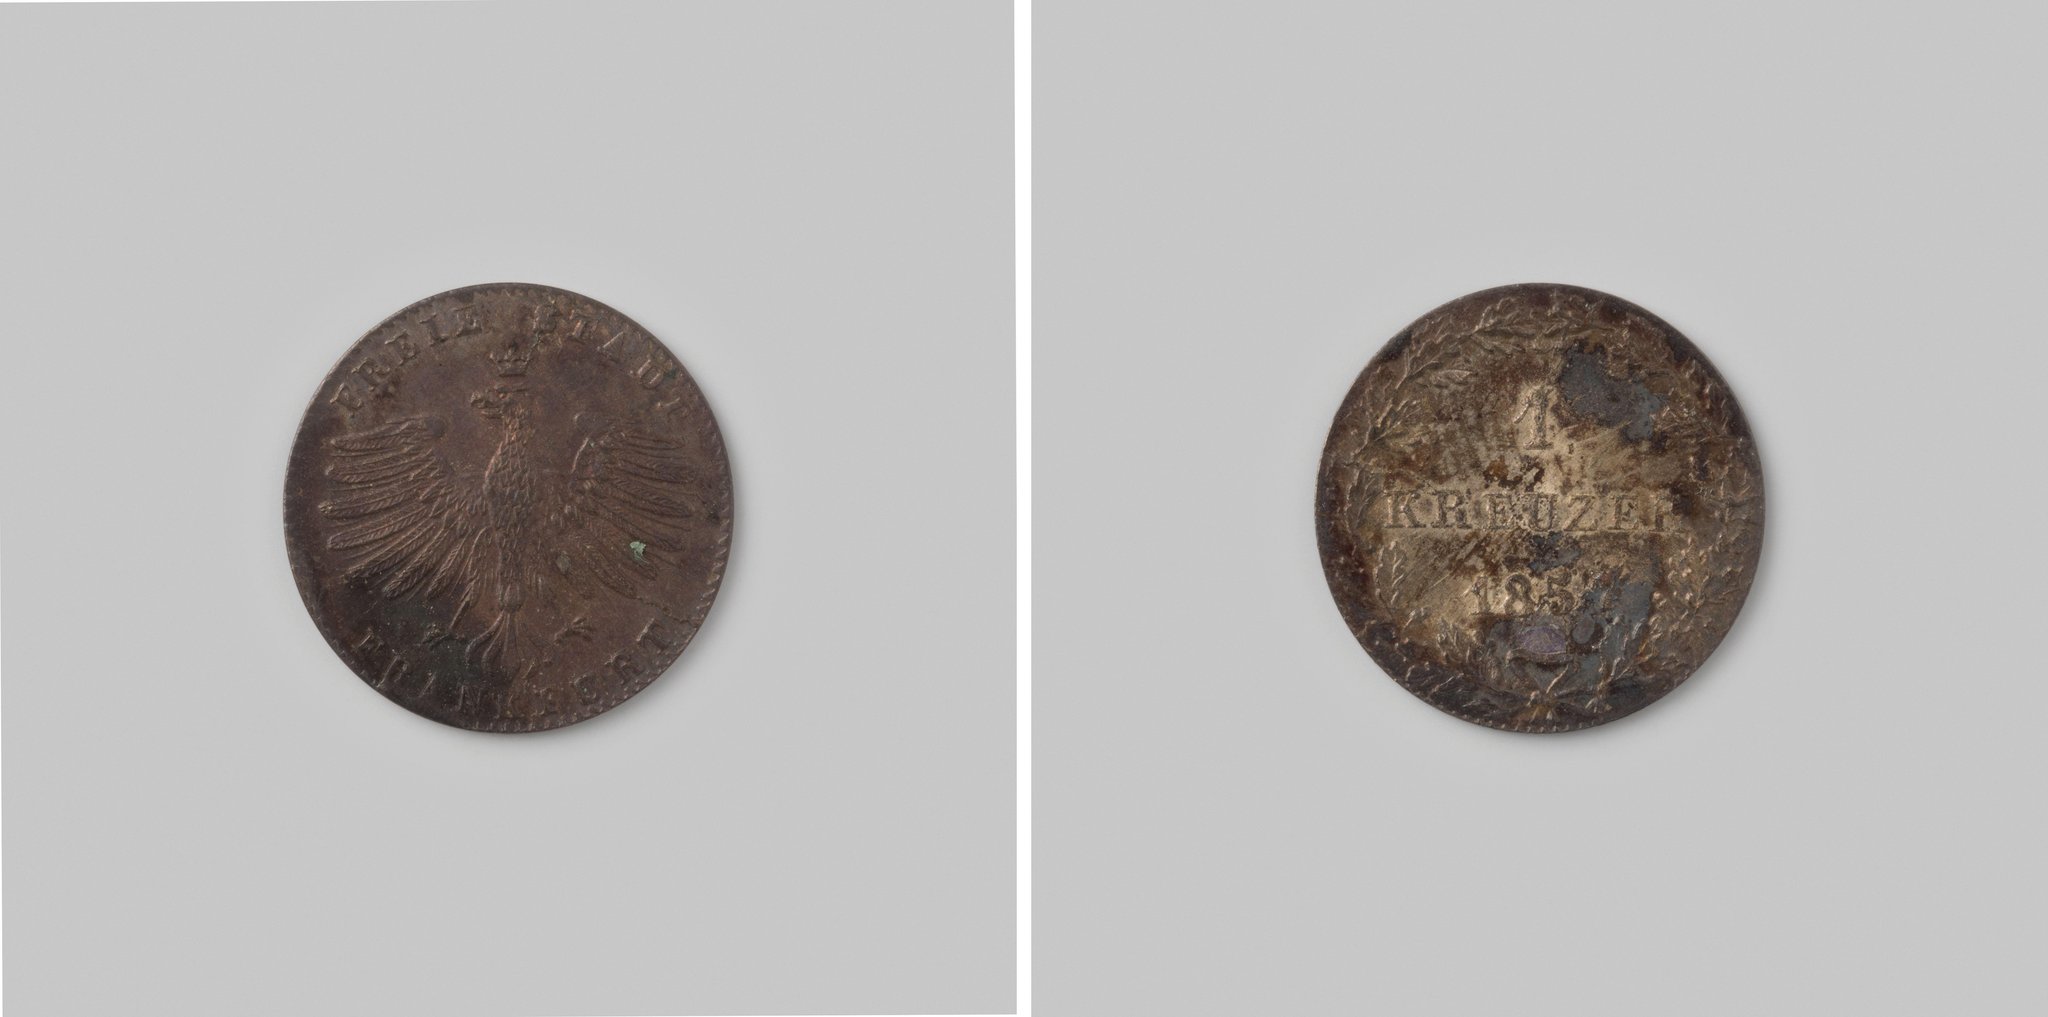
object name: coin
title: Kreuzer van de vrije rijksstad Frankfurt am Main, 1857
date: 1857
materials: silver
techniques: striking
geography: frankfurt am main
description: Zilveren munt. Voorzijde: gekroonde enkelkoppige adelaar. Keerzijde: binnen twee samengebonden eiketakken in twee regels waarde-aanduiding, waaronder jaartal. Gladde rand.